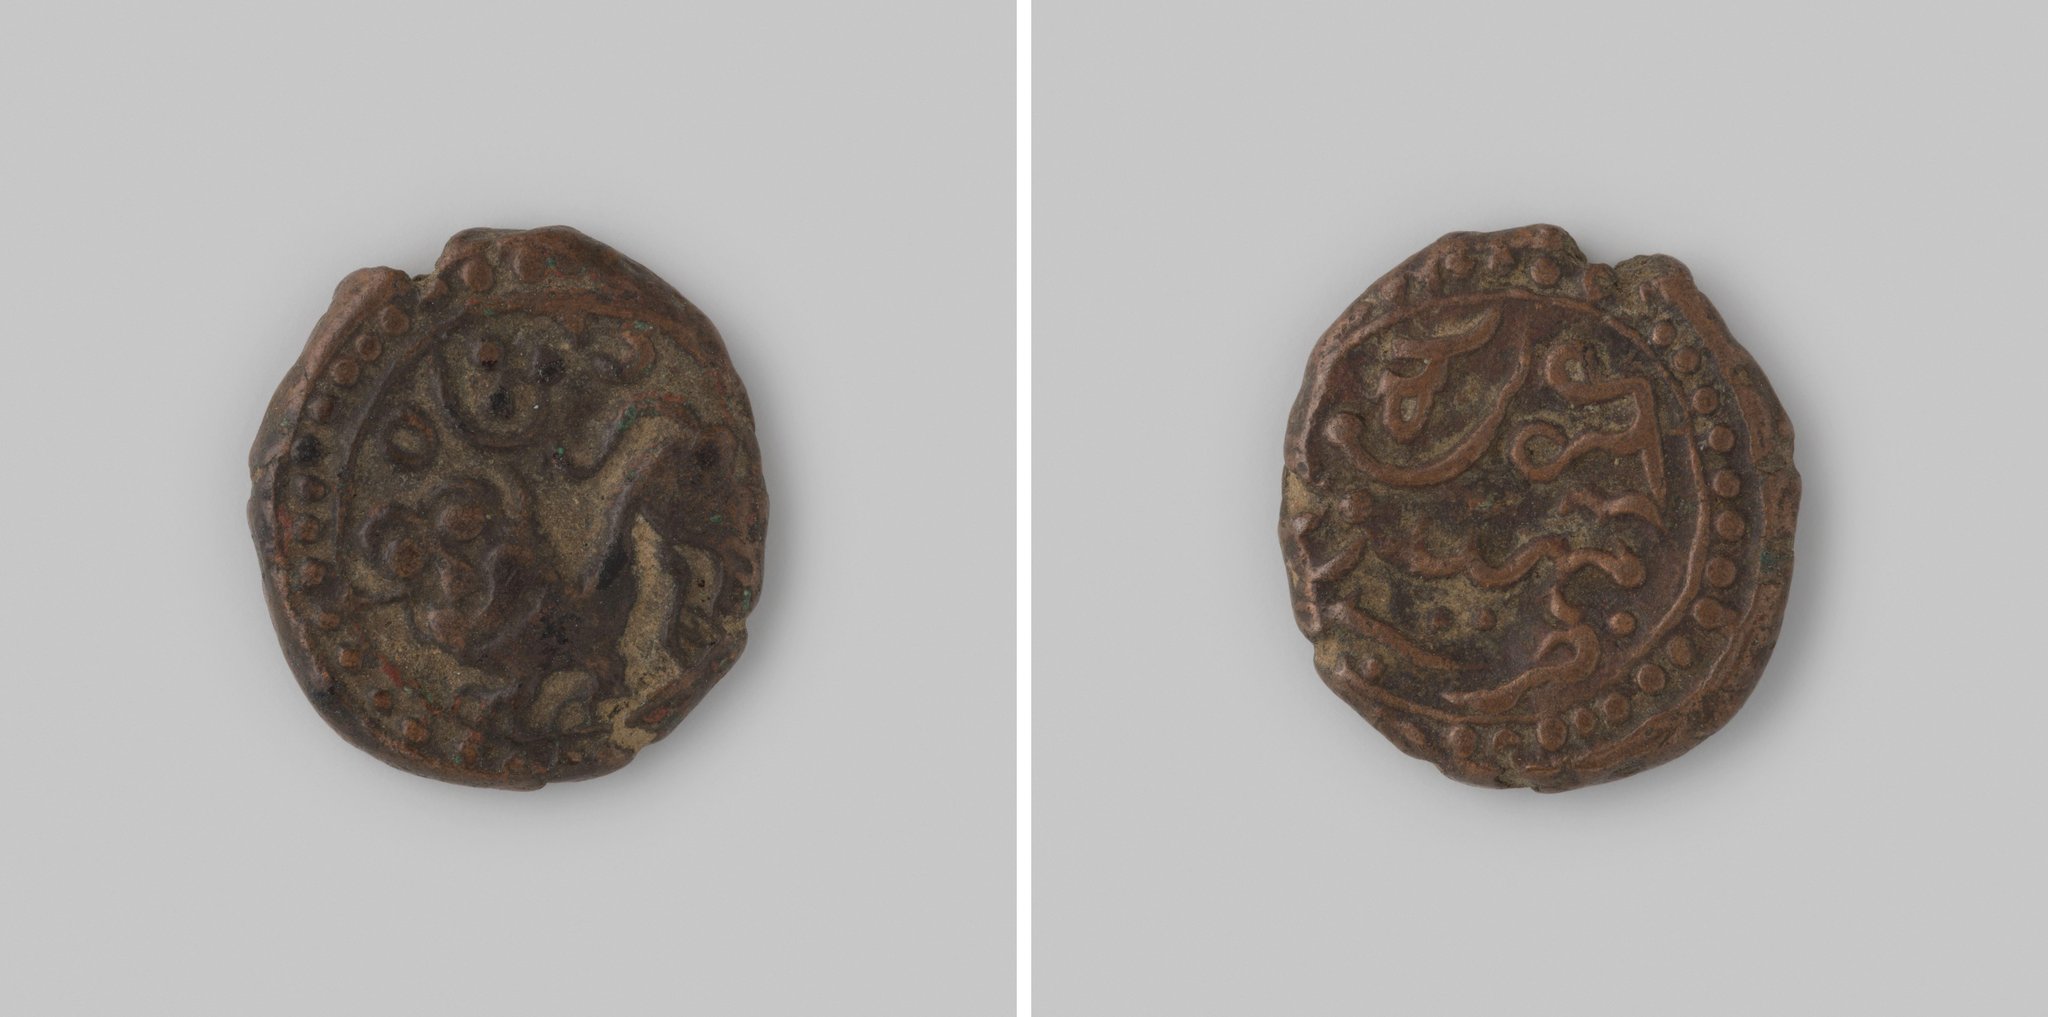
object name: coin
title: Mysore, India, 6 1/4 cash, Sri Krishna Raya Wodeyar,1799-1868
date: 1799-1868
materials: copper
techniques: striking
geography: mysore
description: Koperen munt. Voorzijde: mythologische leeuw: Sardula naar links. Boven hem tussen zon en maan in Kanarees schrift de aanduiding Sri, waaronder een regelig opschrift. Keerzijde: in Kanarees schrift tweeregelig opschrift. Daaronder in Arabisch schrift muntplaats-aanduiding: Mysore.